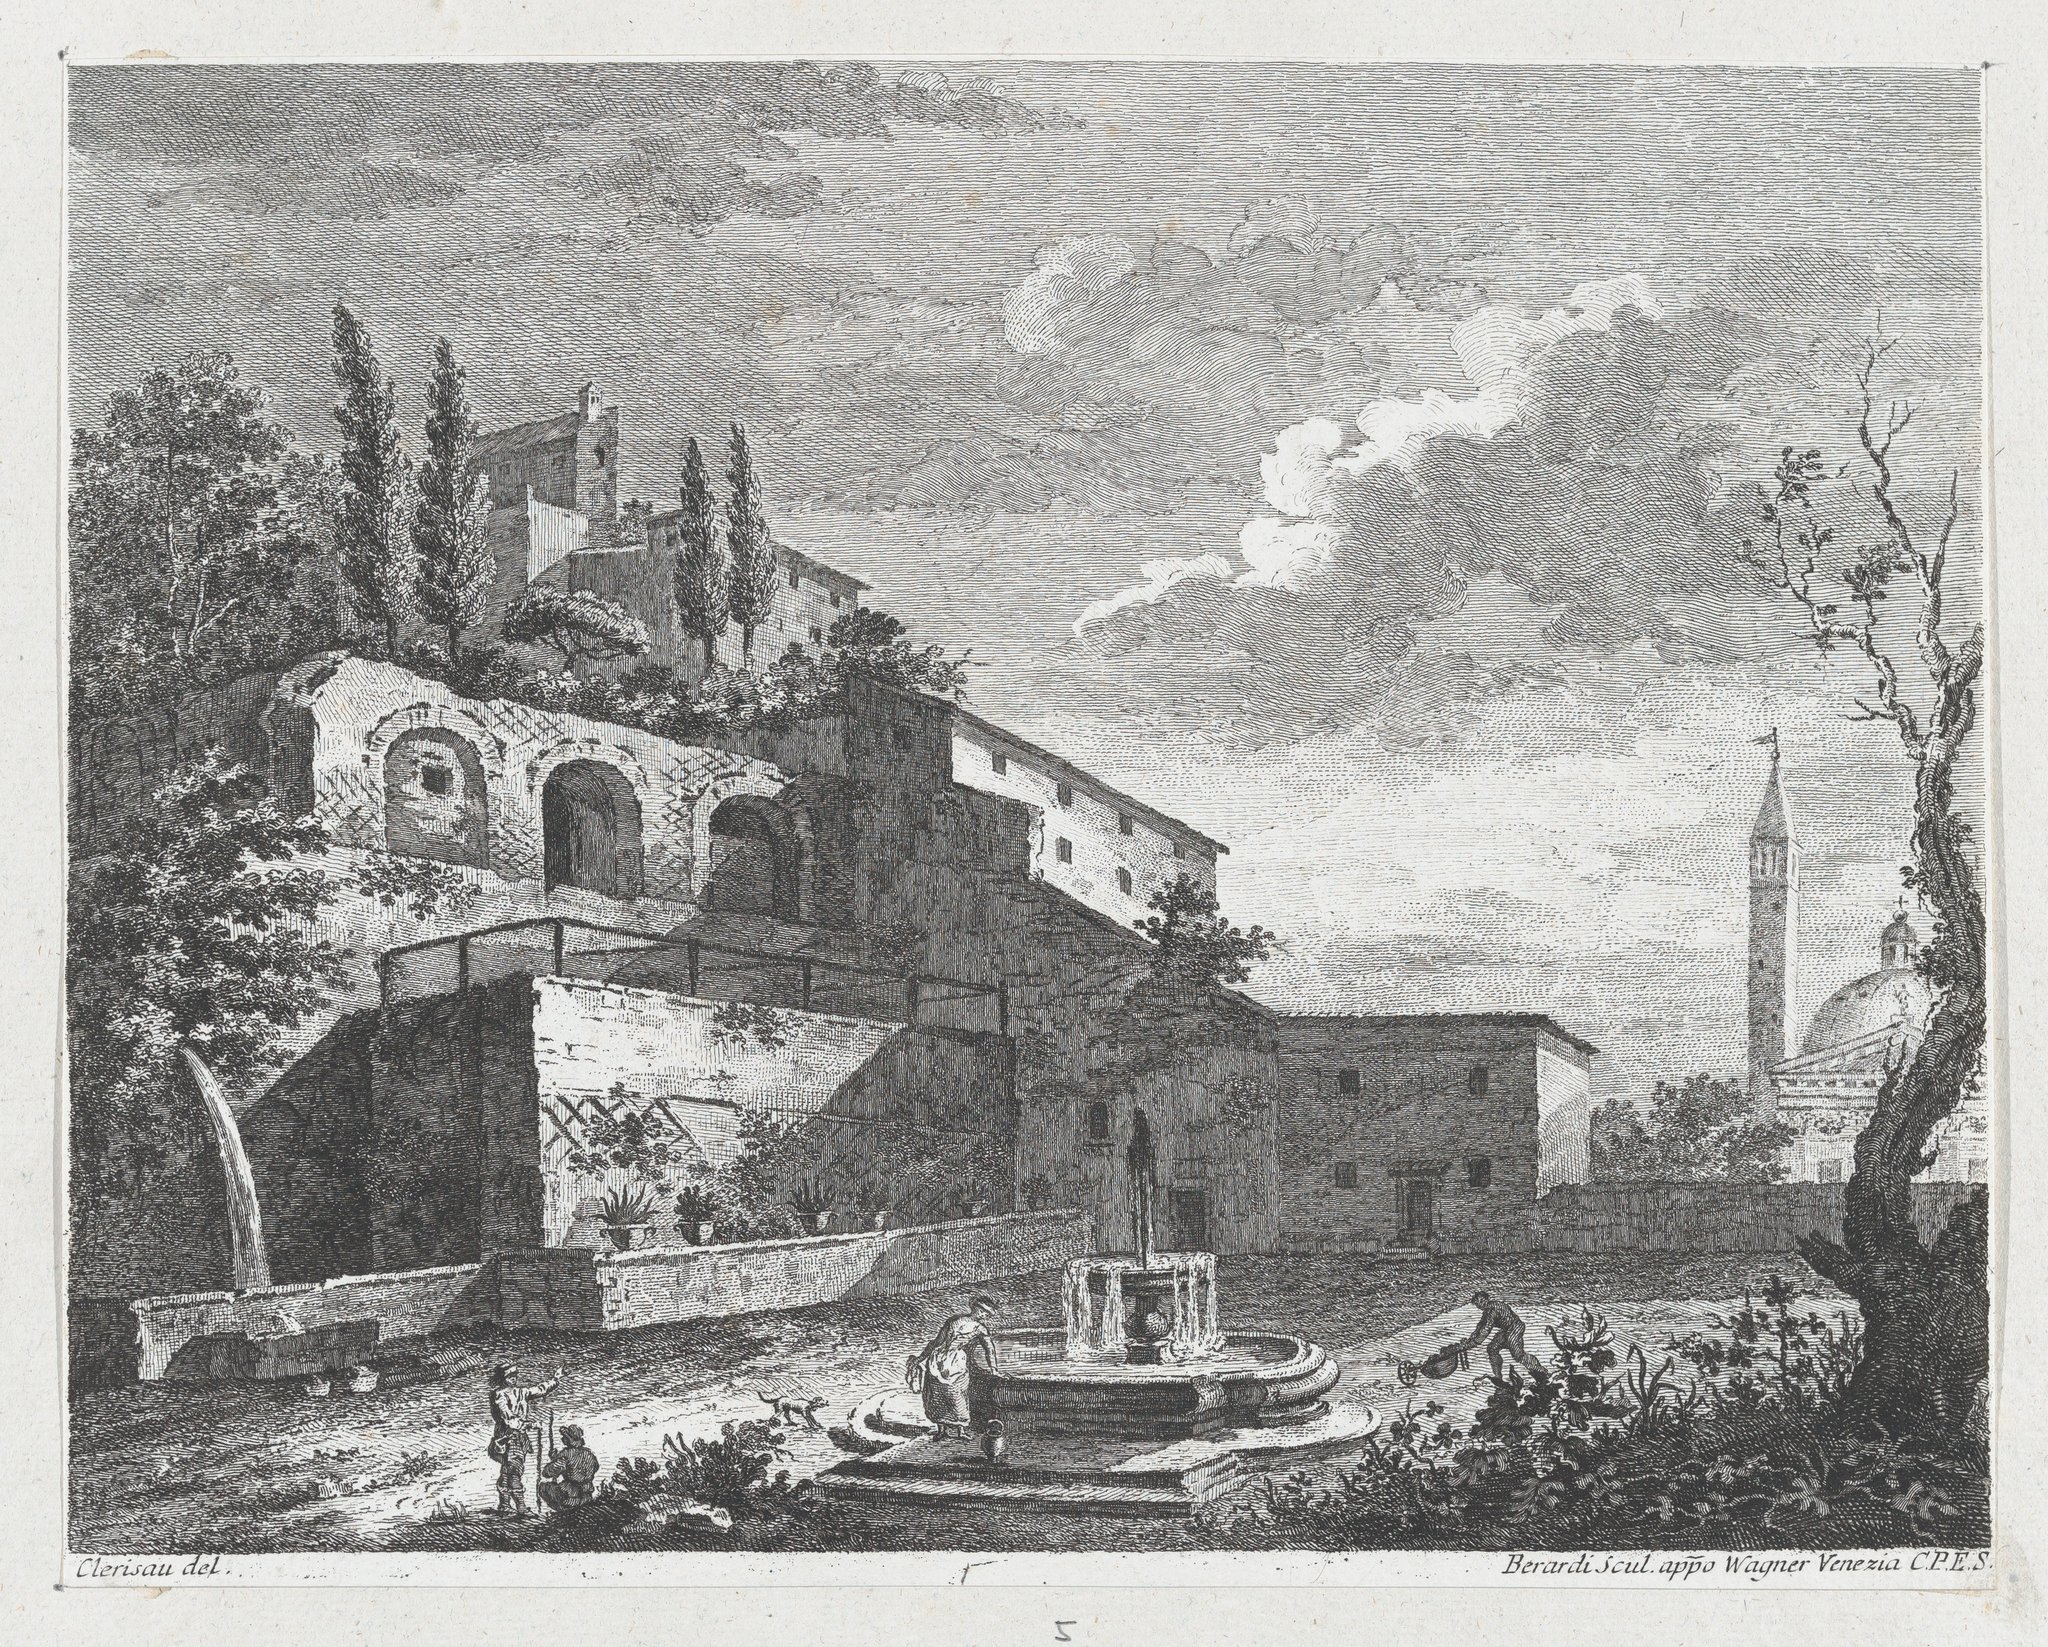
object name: print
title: Landscape with Ruins and Fountain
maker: fabio berardi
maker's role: artist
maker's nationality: italian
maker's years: 1728-1788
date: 1750-1770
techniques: etching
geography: venice